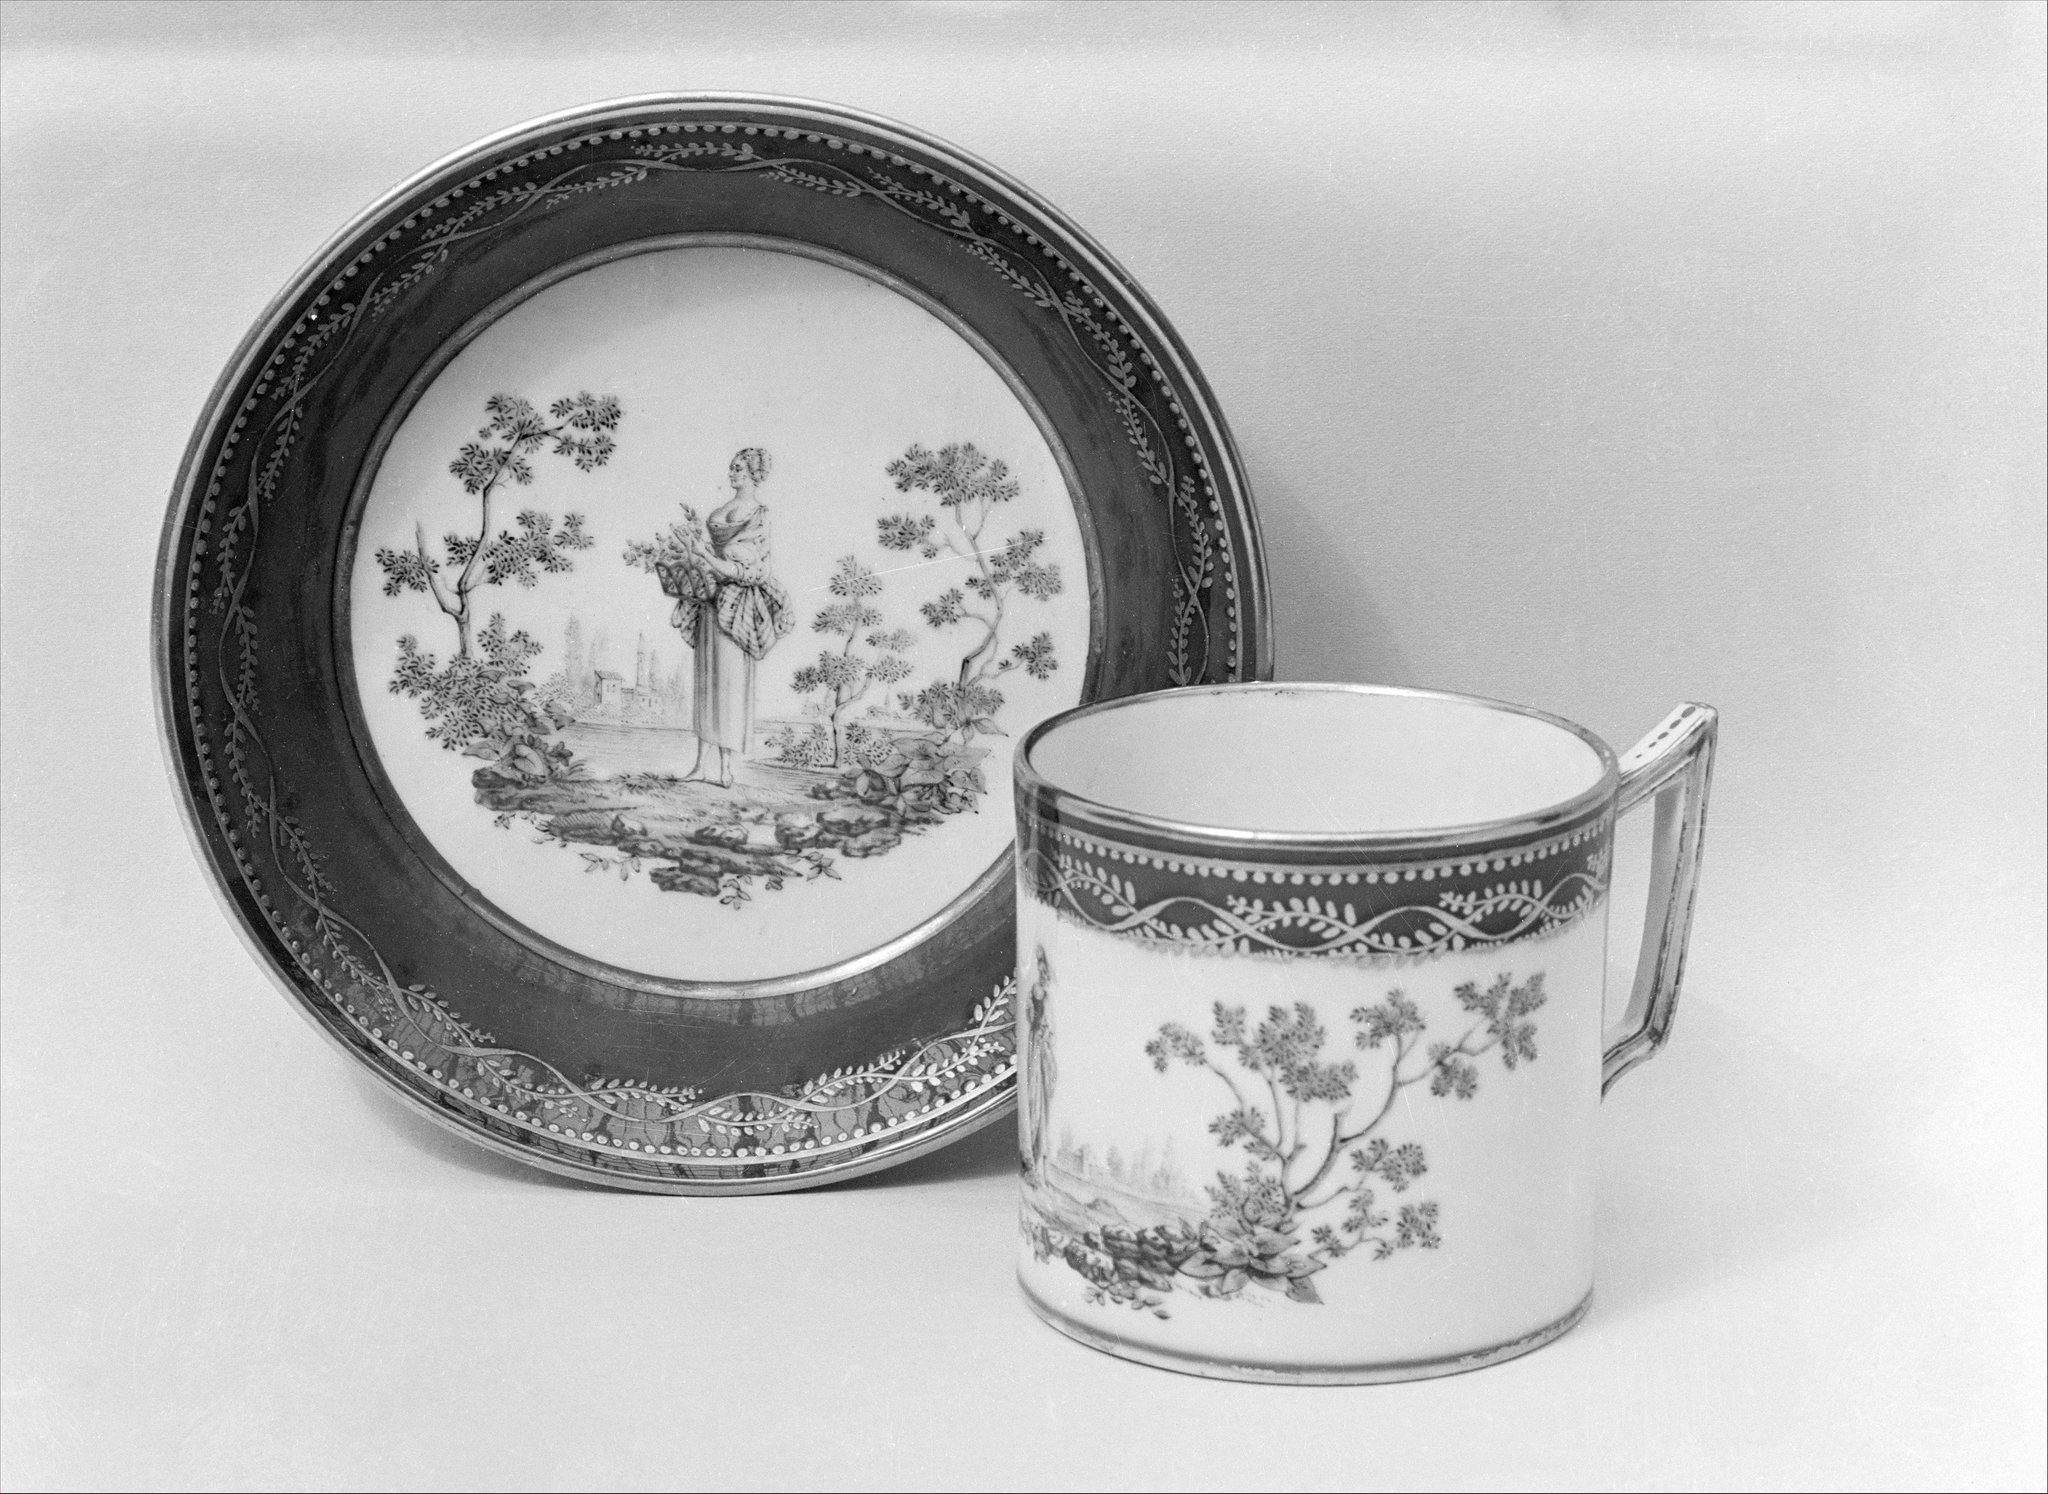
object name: cup and saucer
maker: tournai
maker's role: factory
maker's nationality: belgian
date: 1701-1800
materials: soft paste porcelain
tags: women,trees